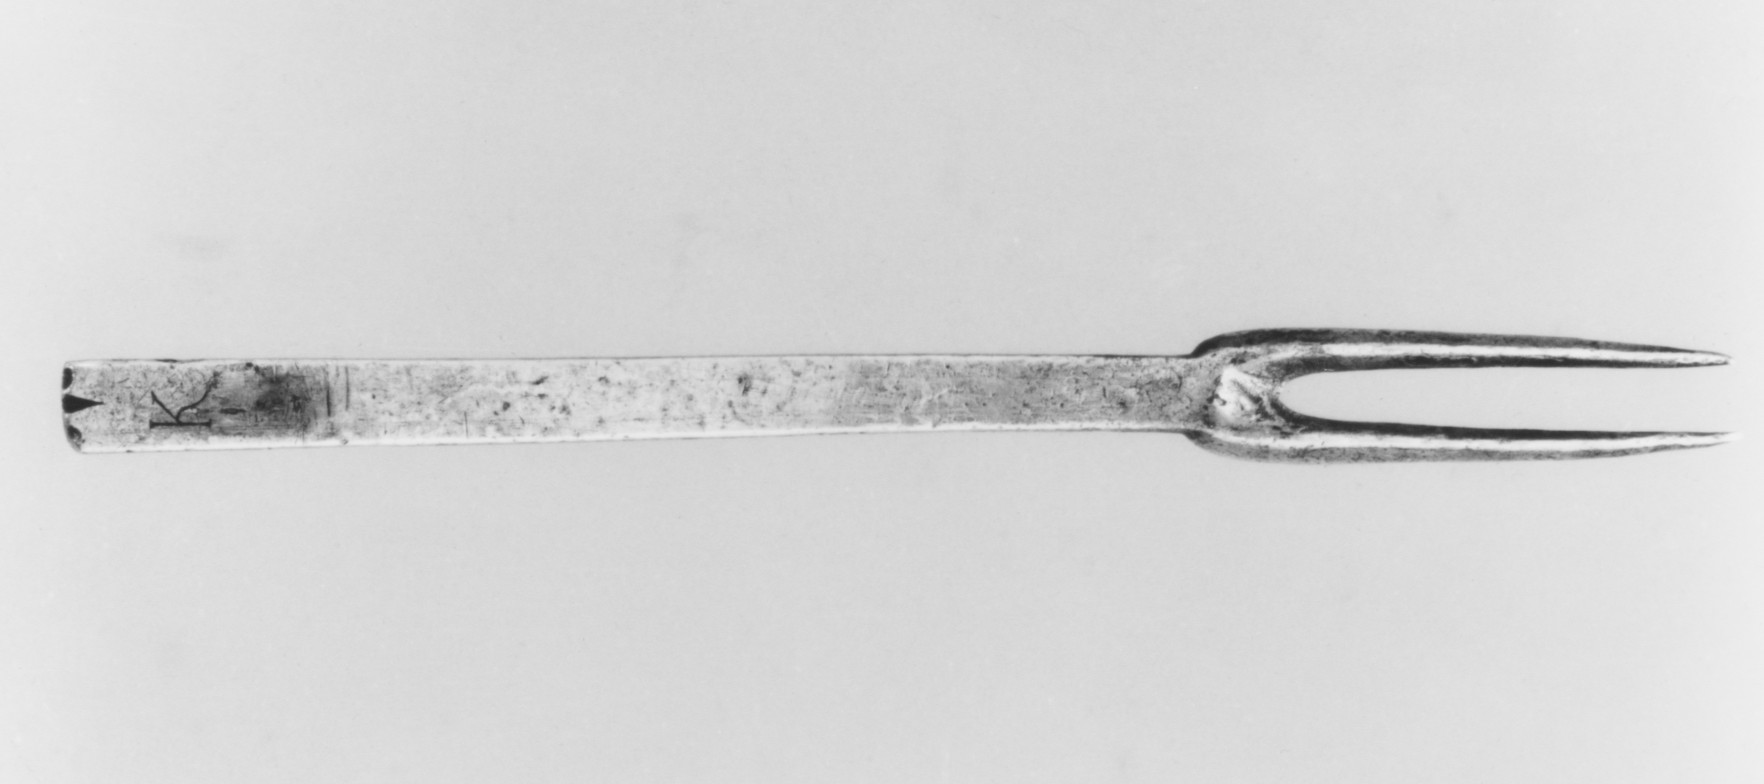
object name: fork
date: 1622-1623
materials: silver